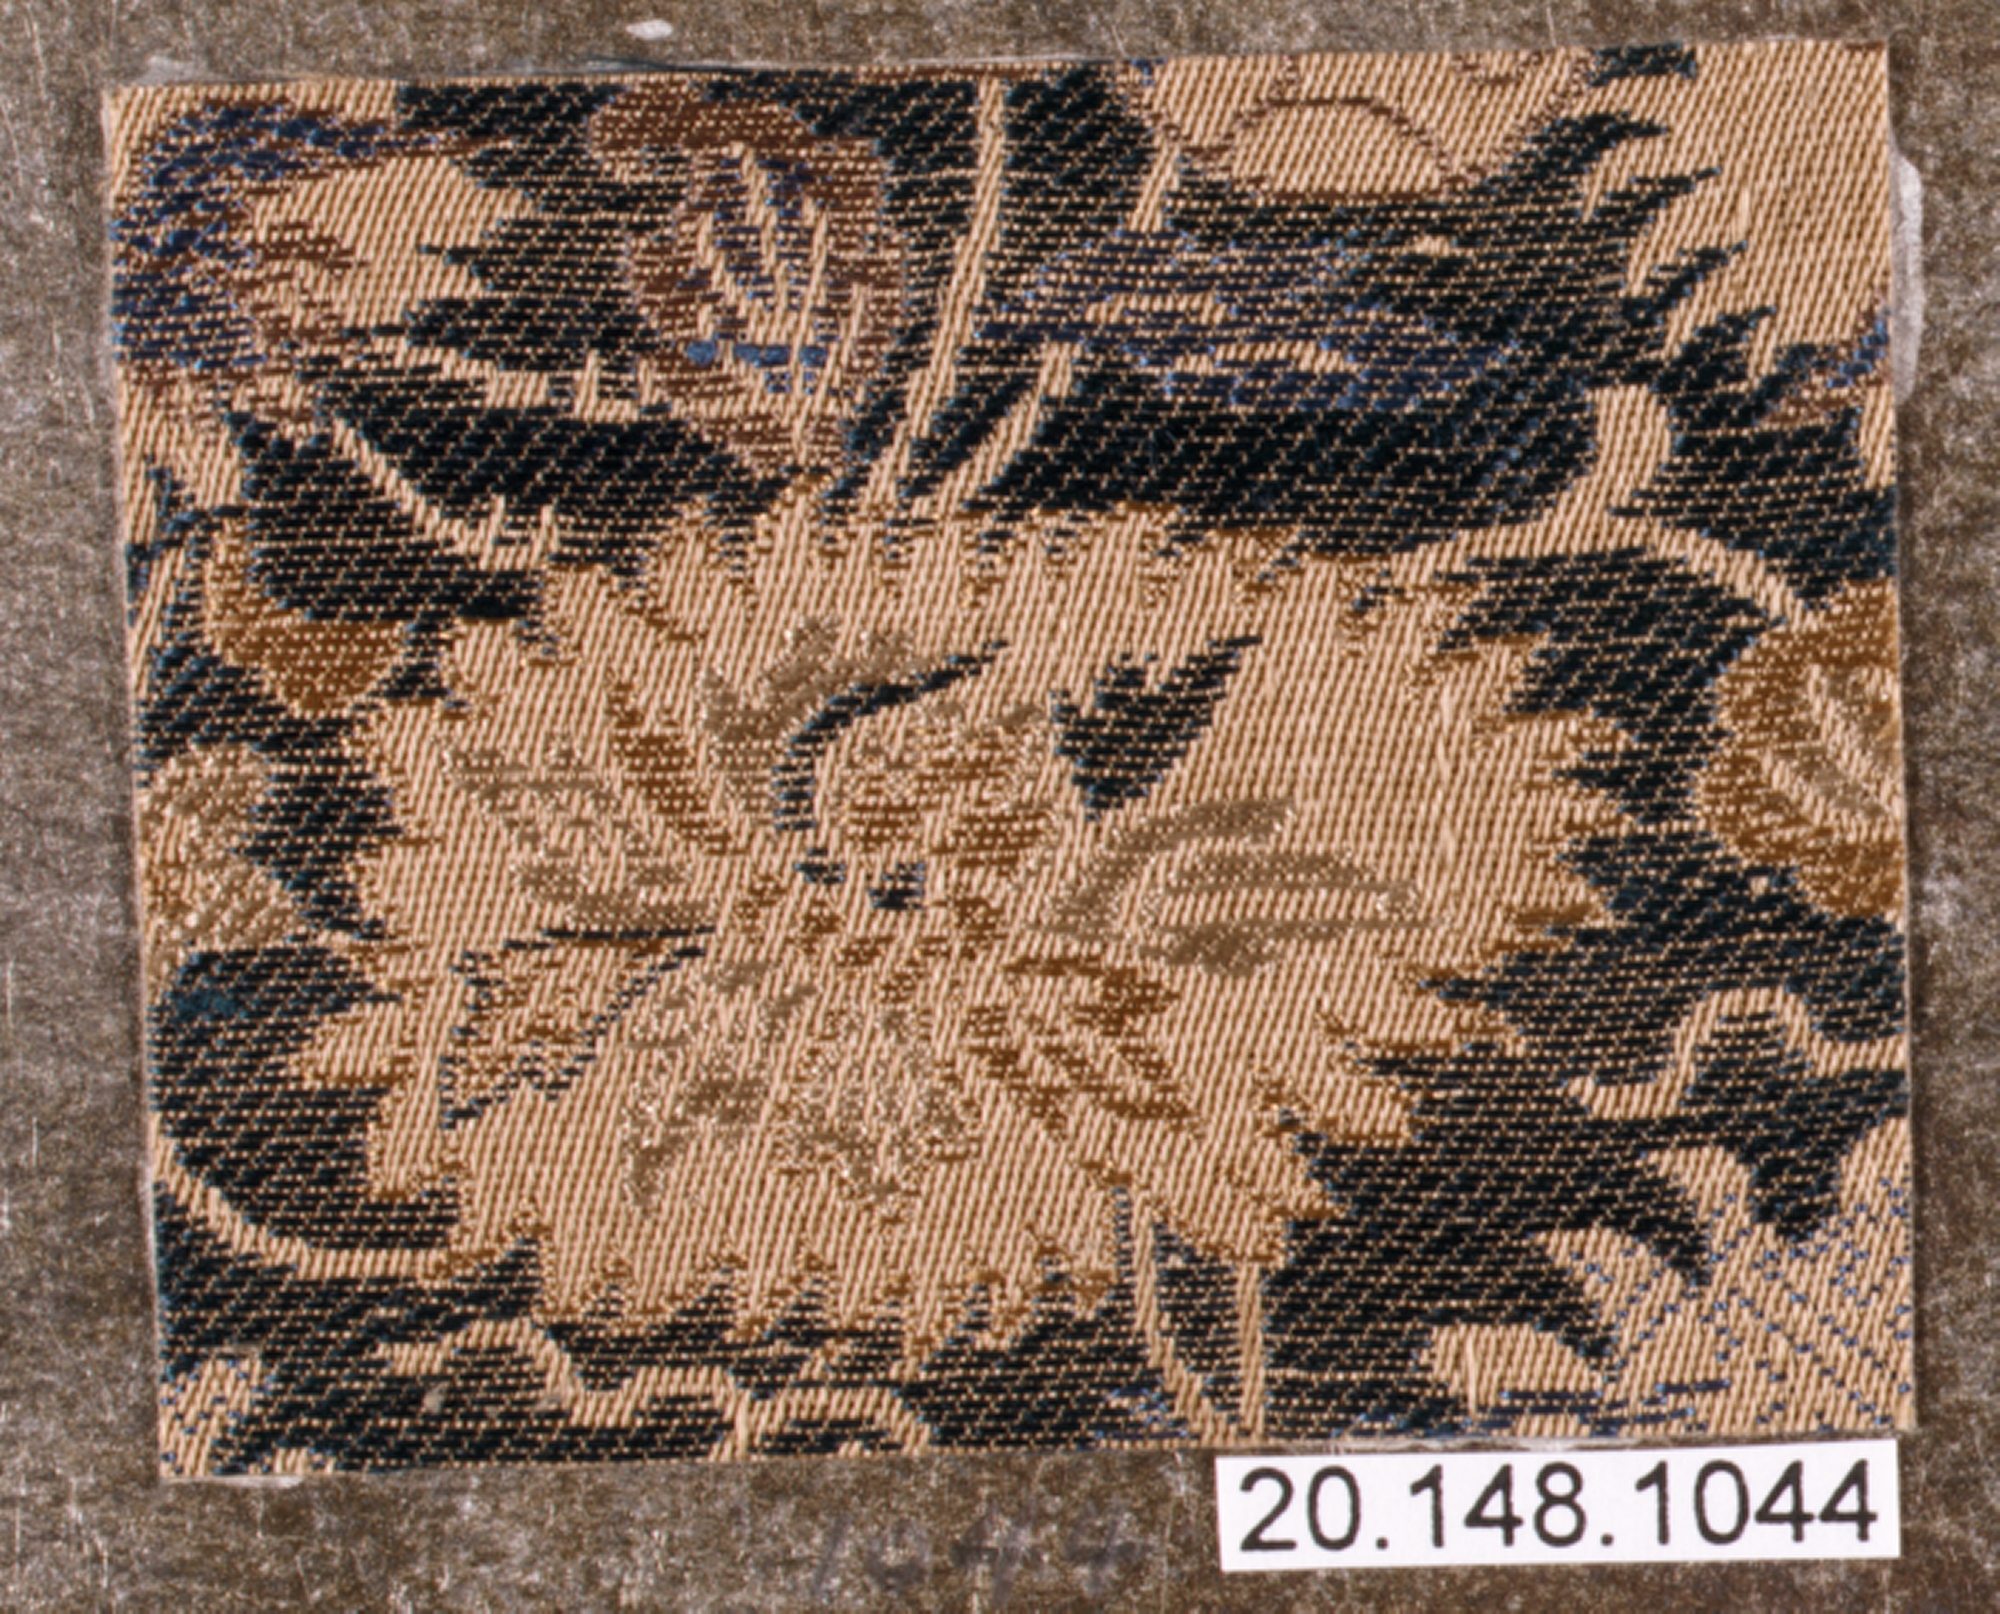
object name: piece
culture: japanese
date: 1701-1800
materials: silk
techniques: compound weave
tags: flowers